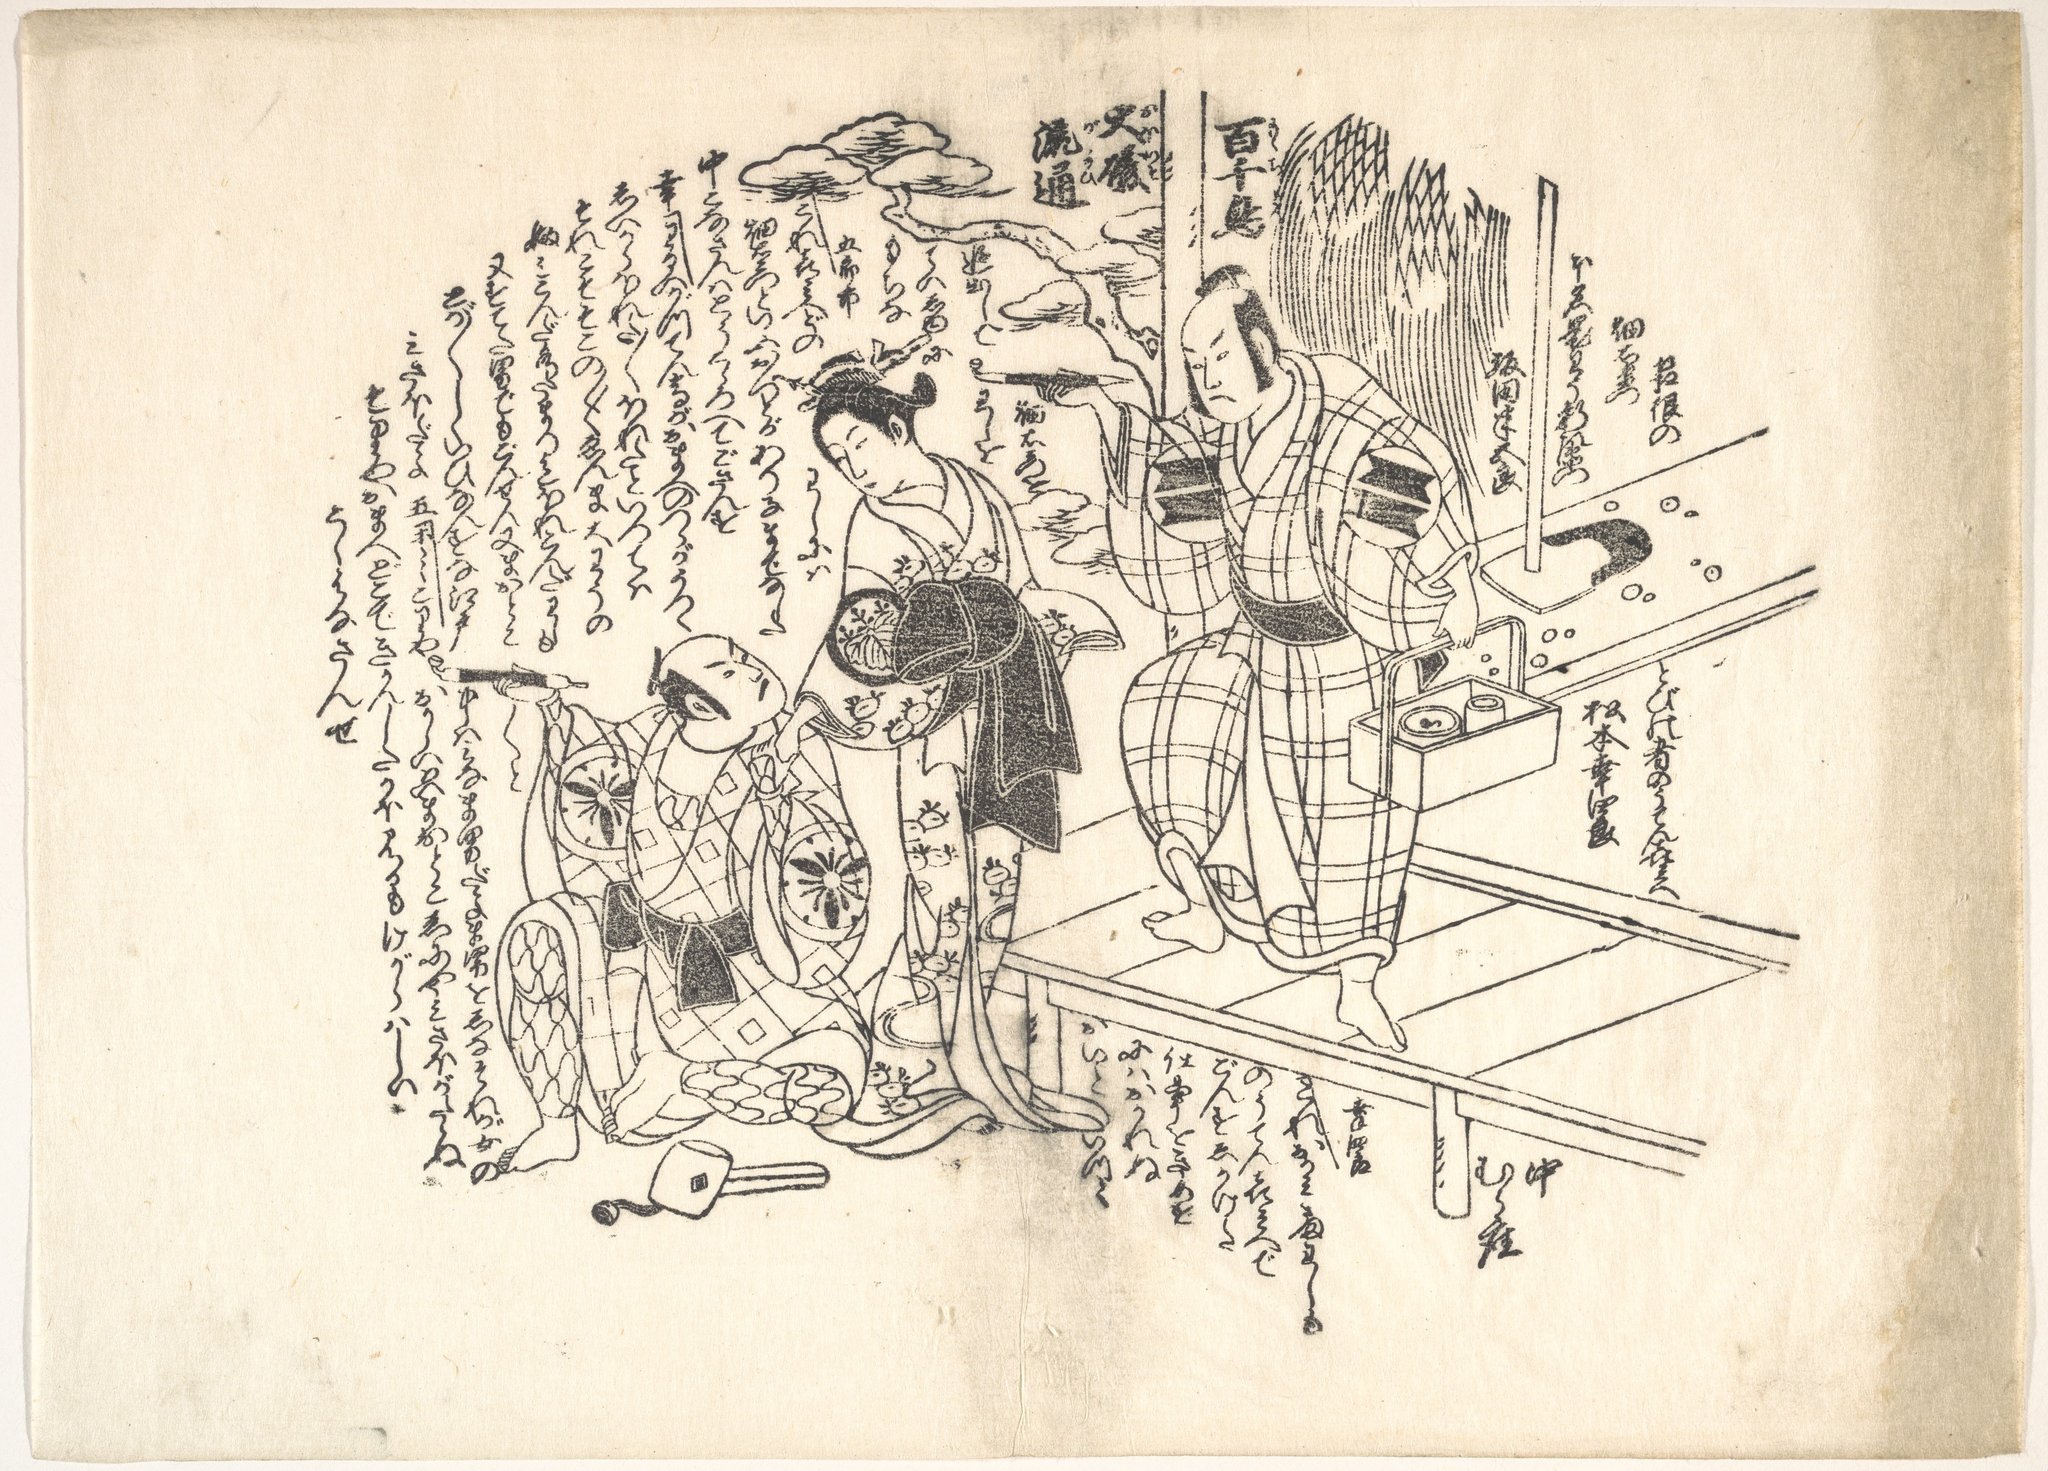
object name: print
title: One of Six Impressions from Worn Old Blocks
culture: japanese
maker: unidentified artist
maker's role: artist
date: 1700-1799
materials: ink, paper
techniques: woodblock print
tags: men,women